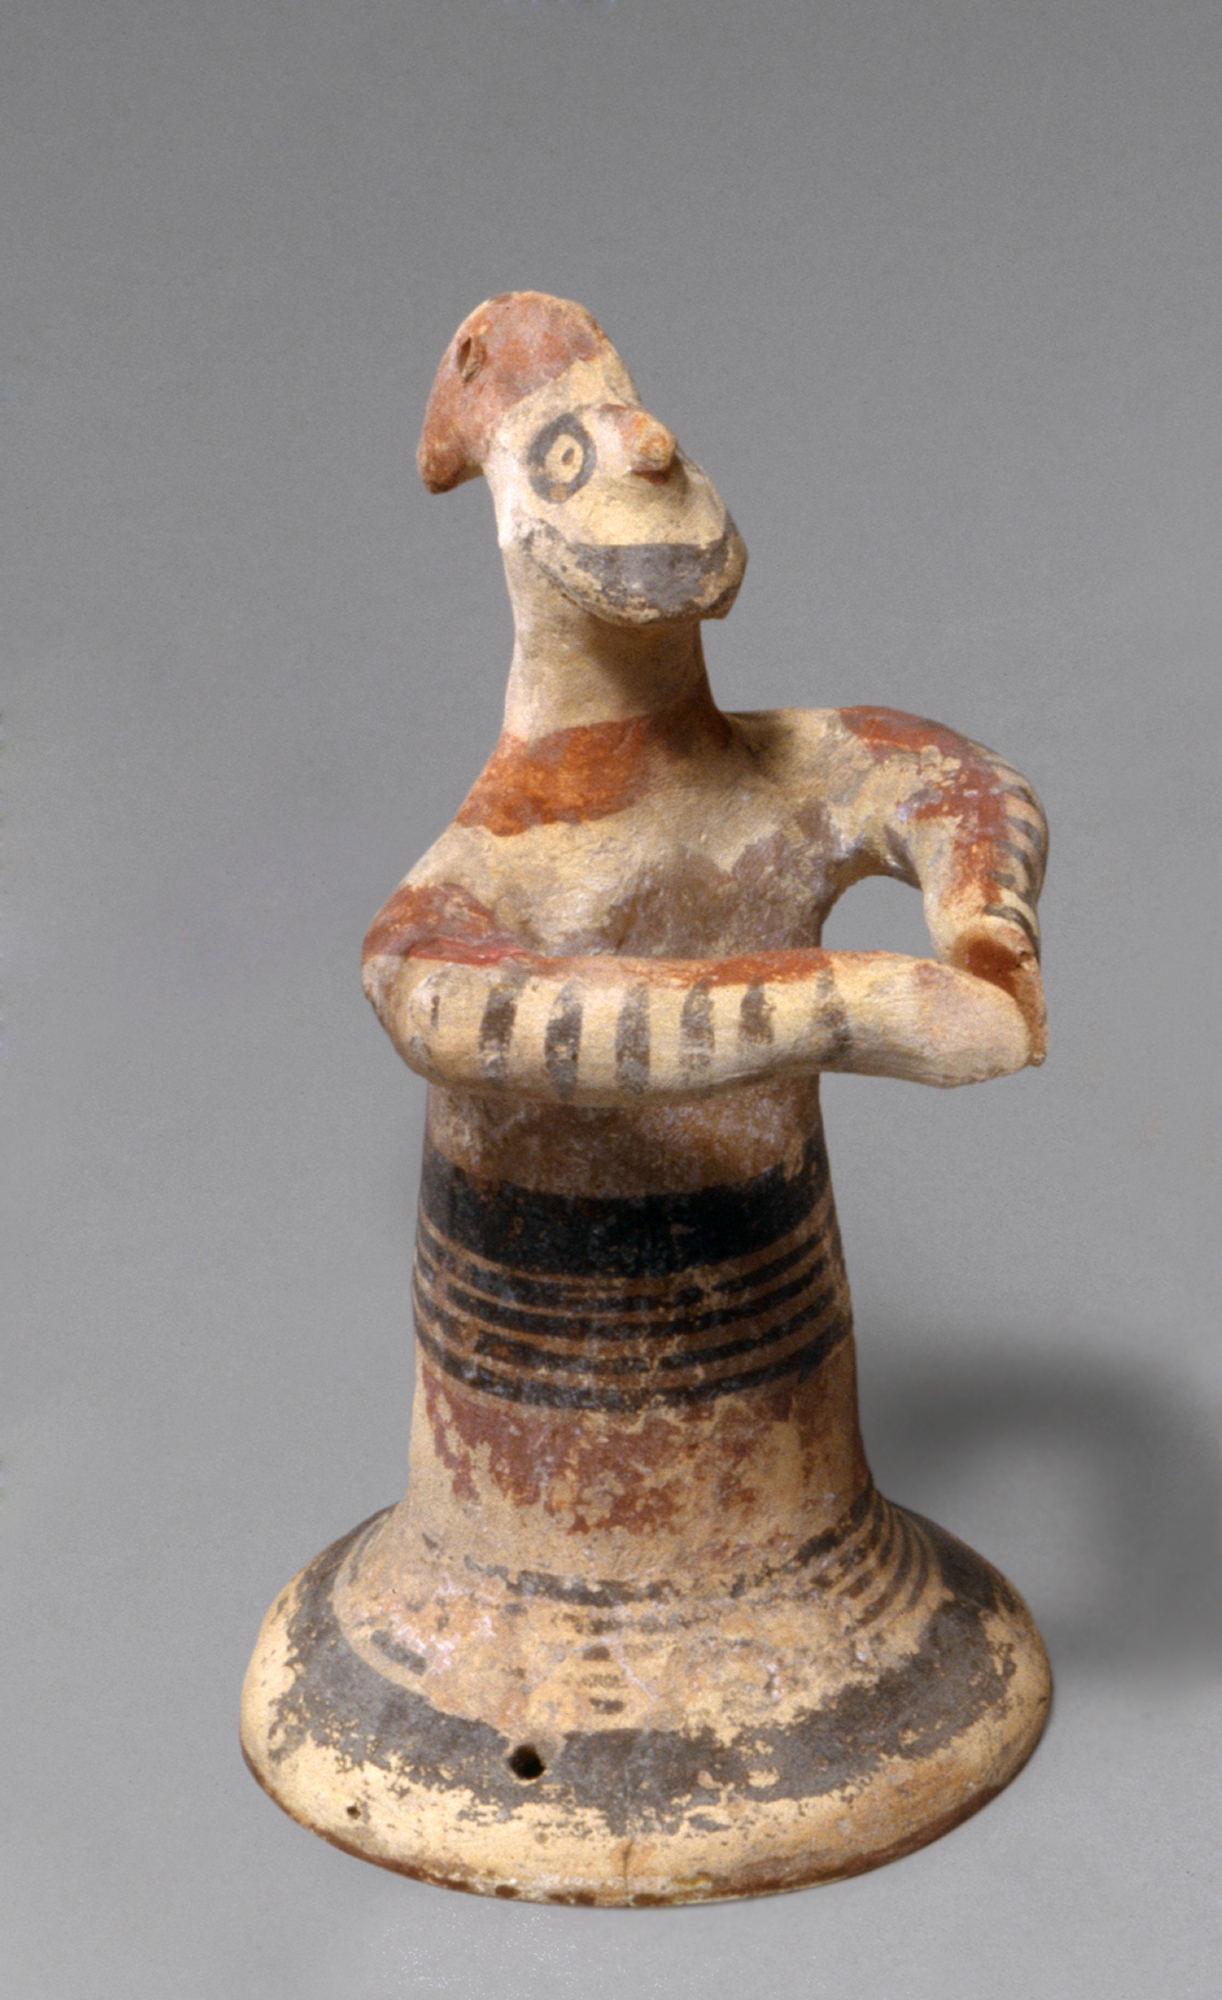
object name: statuette of a man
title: Terracotta statuette of a man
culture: cypriot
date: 750-600 BCE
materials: terracotta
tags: men